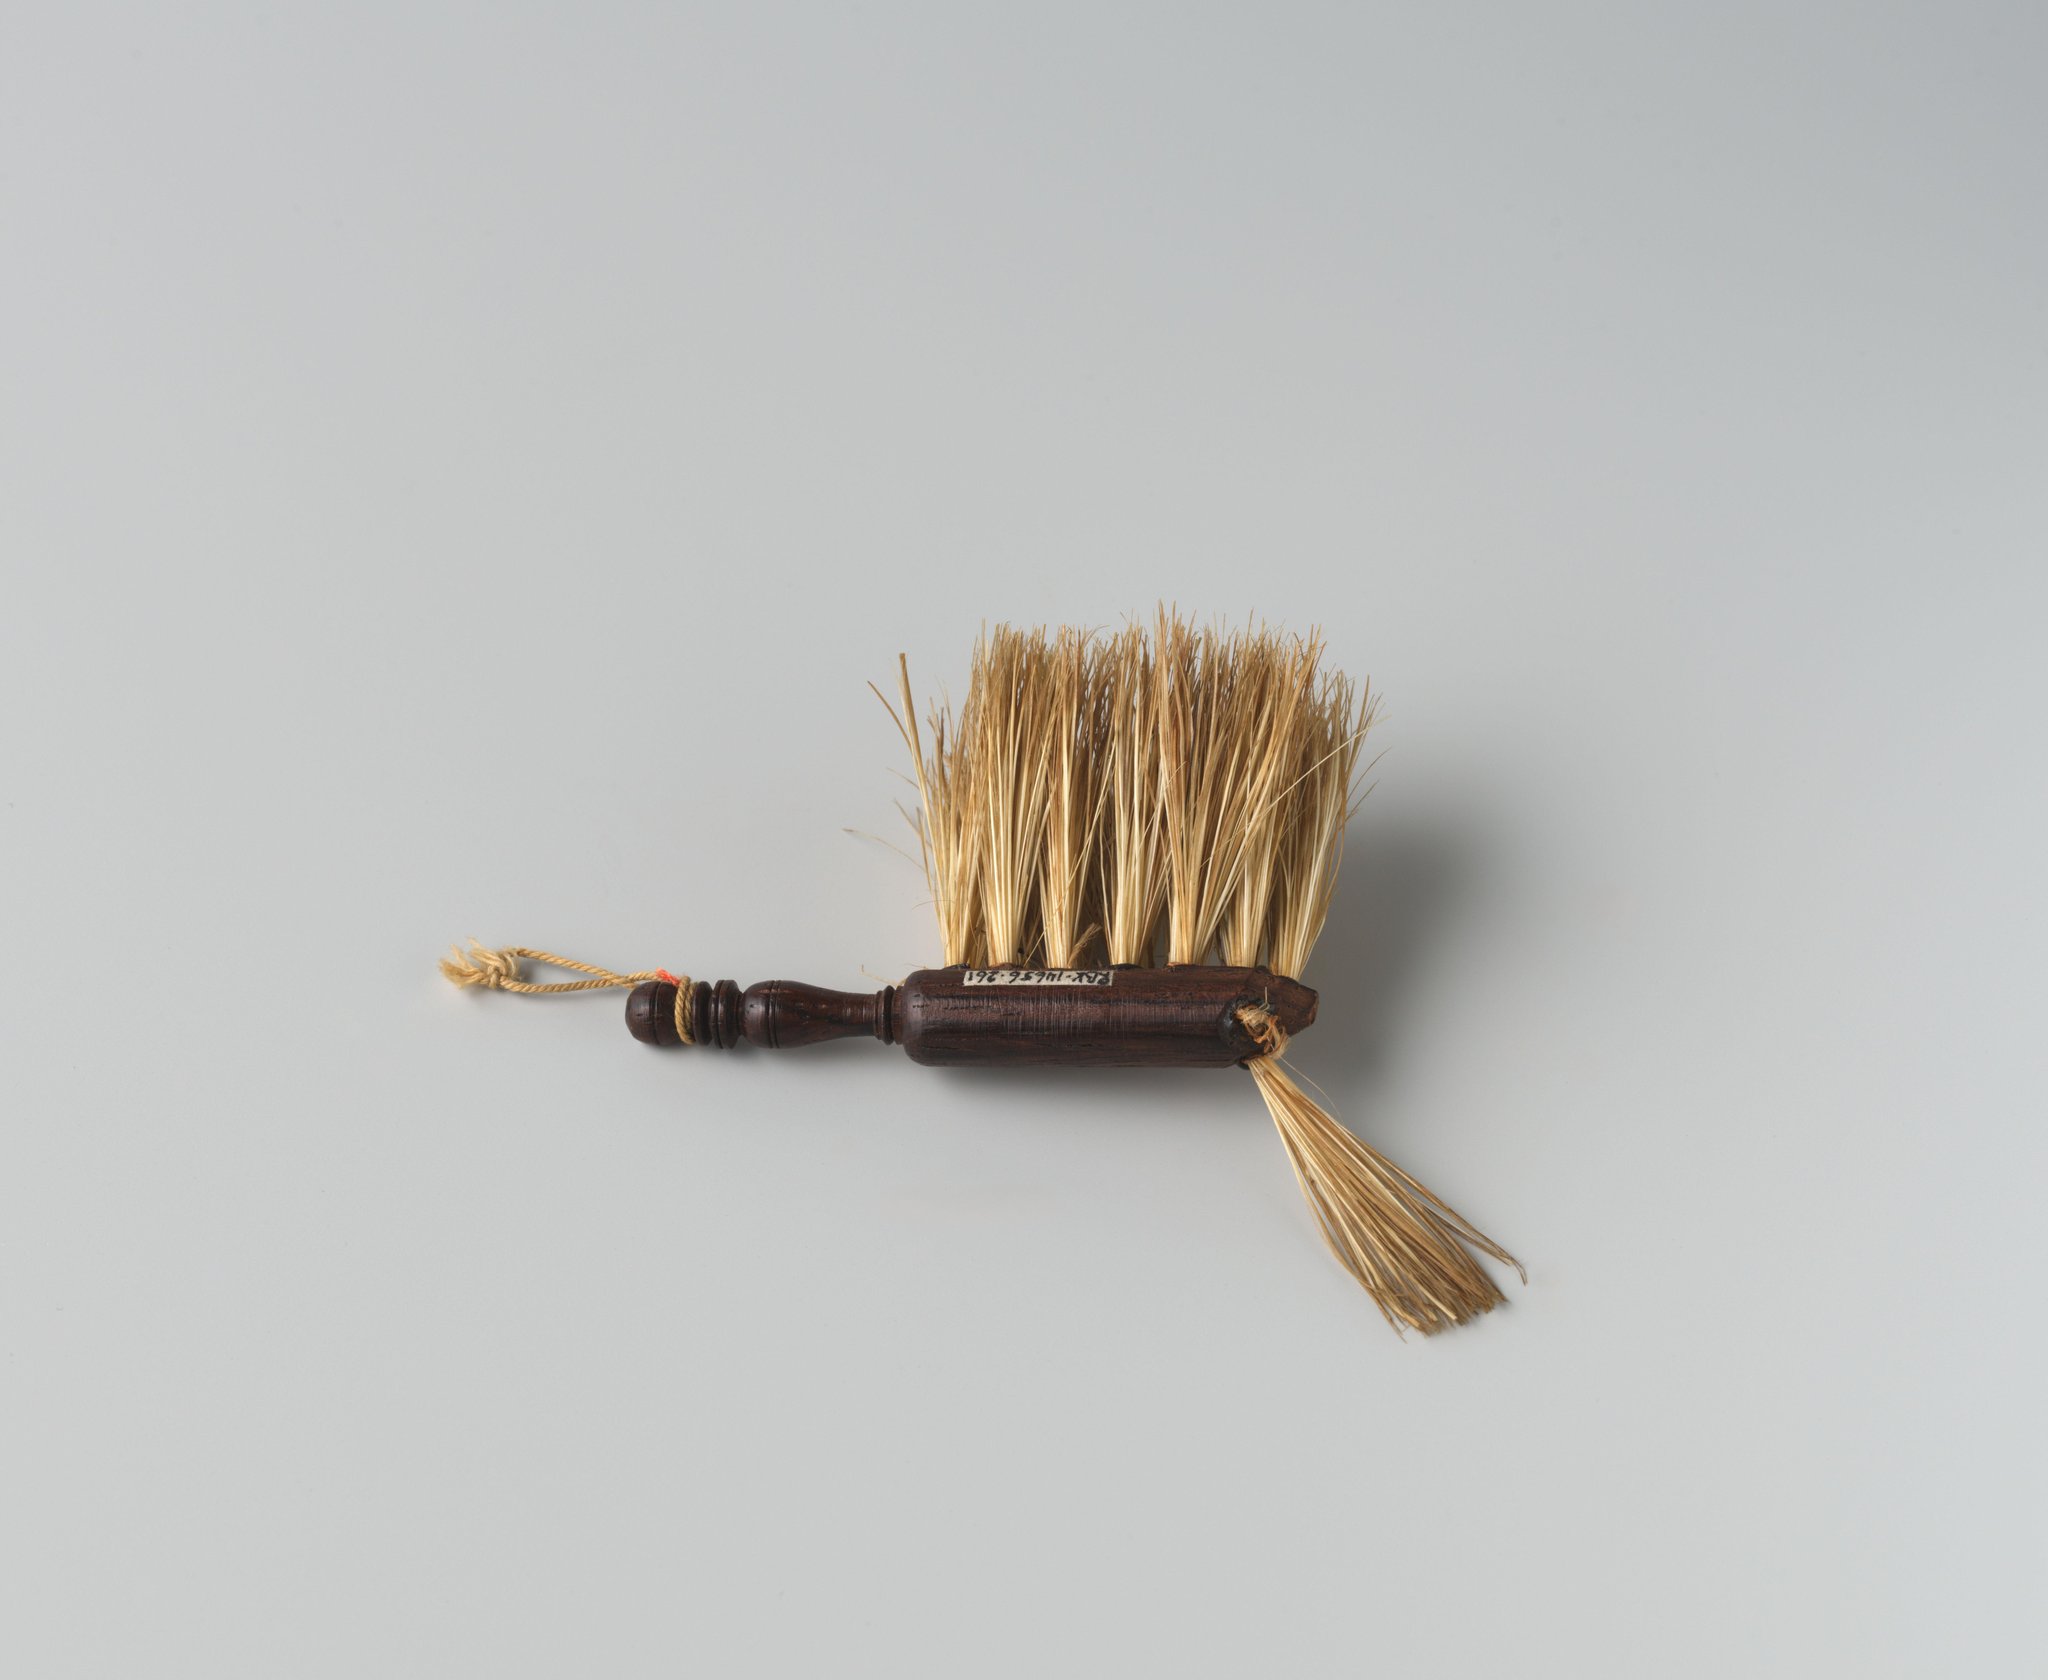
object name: whisk broom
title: Stoffer van palissanderhout en varkenshaar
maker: Anonymous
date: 1676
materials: wood, silk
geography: amsterdam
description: Stoffer van palissanderhout en varkenshaar. De stoffer heeft een ronde rug, aan onderzijde en schuin oplopende voorkant ingezet met haar. De korte gedraaide steel met profielen en balusters. Om de knop restanten van een roze zijden lint.